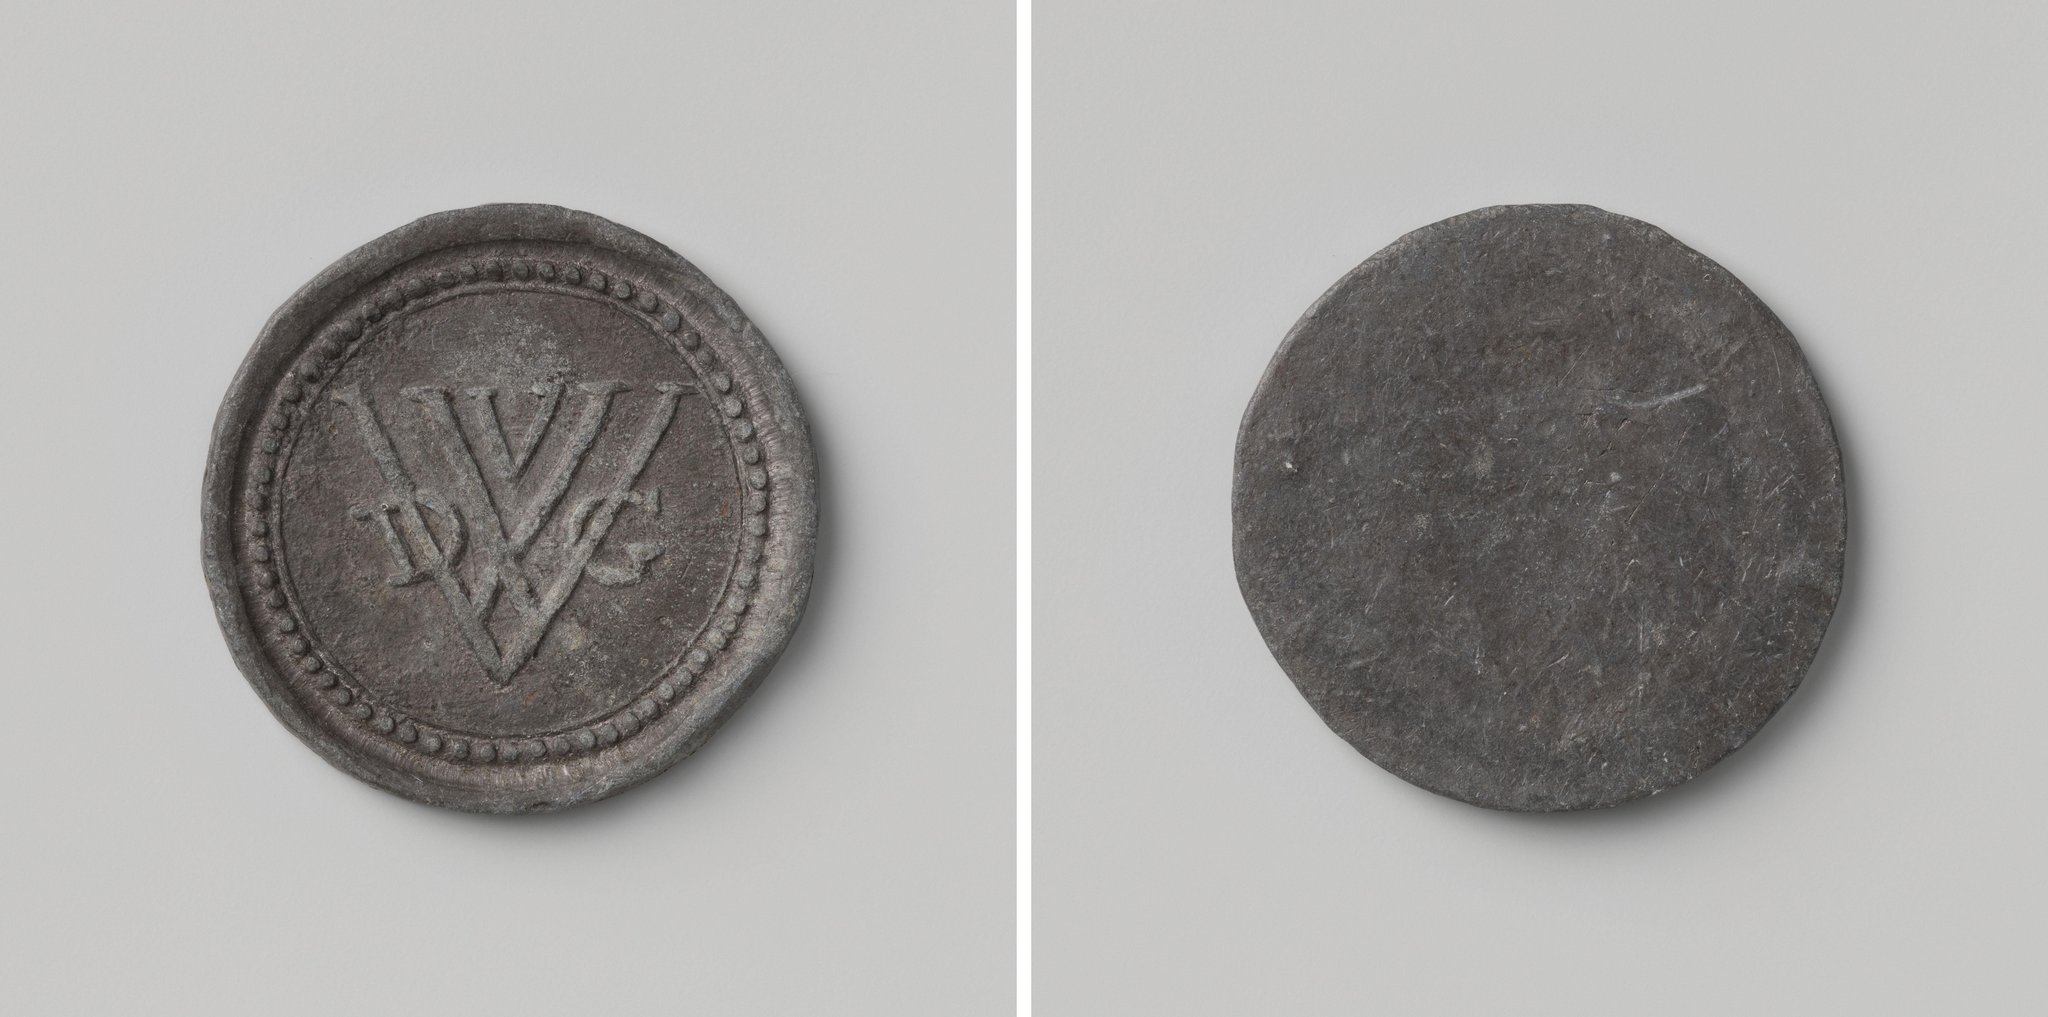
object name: loden penning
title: Armenpenning met opschrift DVWG [?]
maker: Anonymous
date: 1650-1850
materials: lead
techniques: casting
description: Enkelzijdige armenpenning. Voorzijde: monogram van letters D, V, W en G. Keerzijde: blanco.